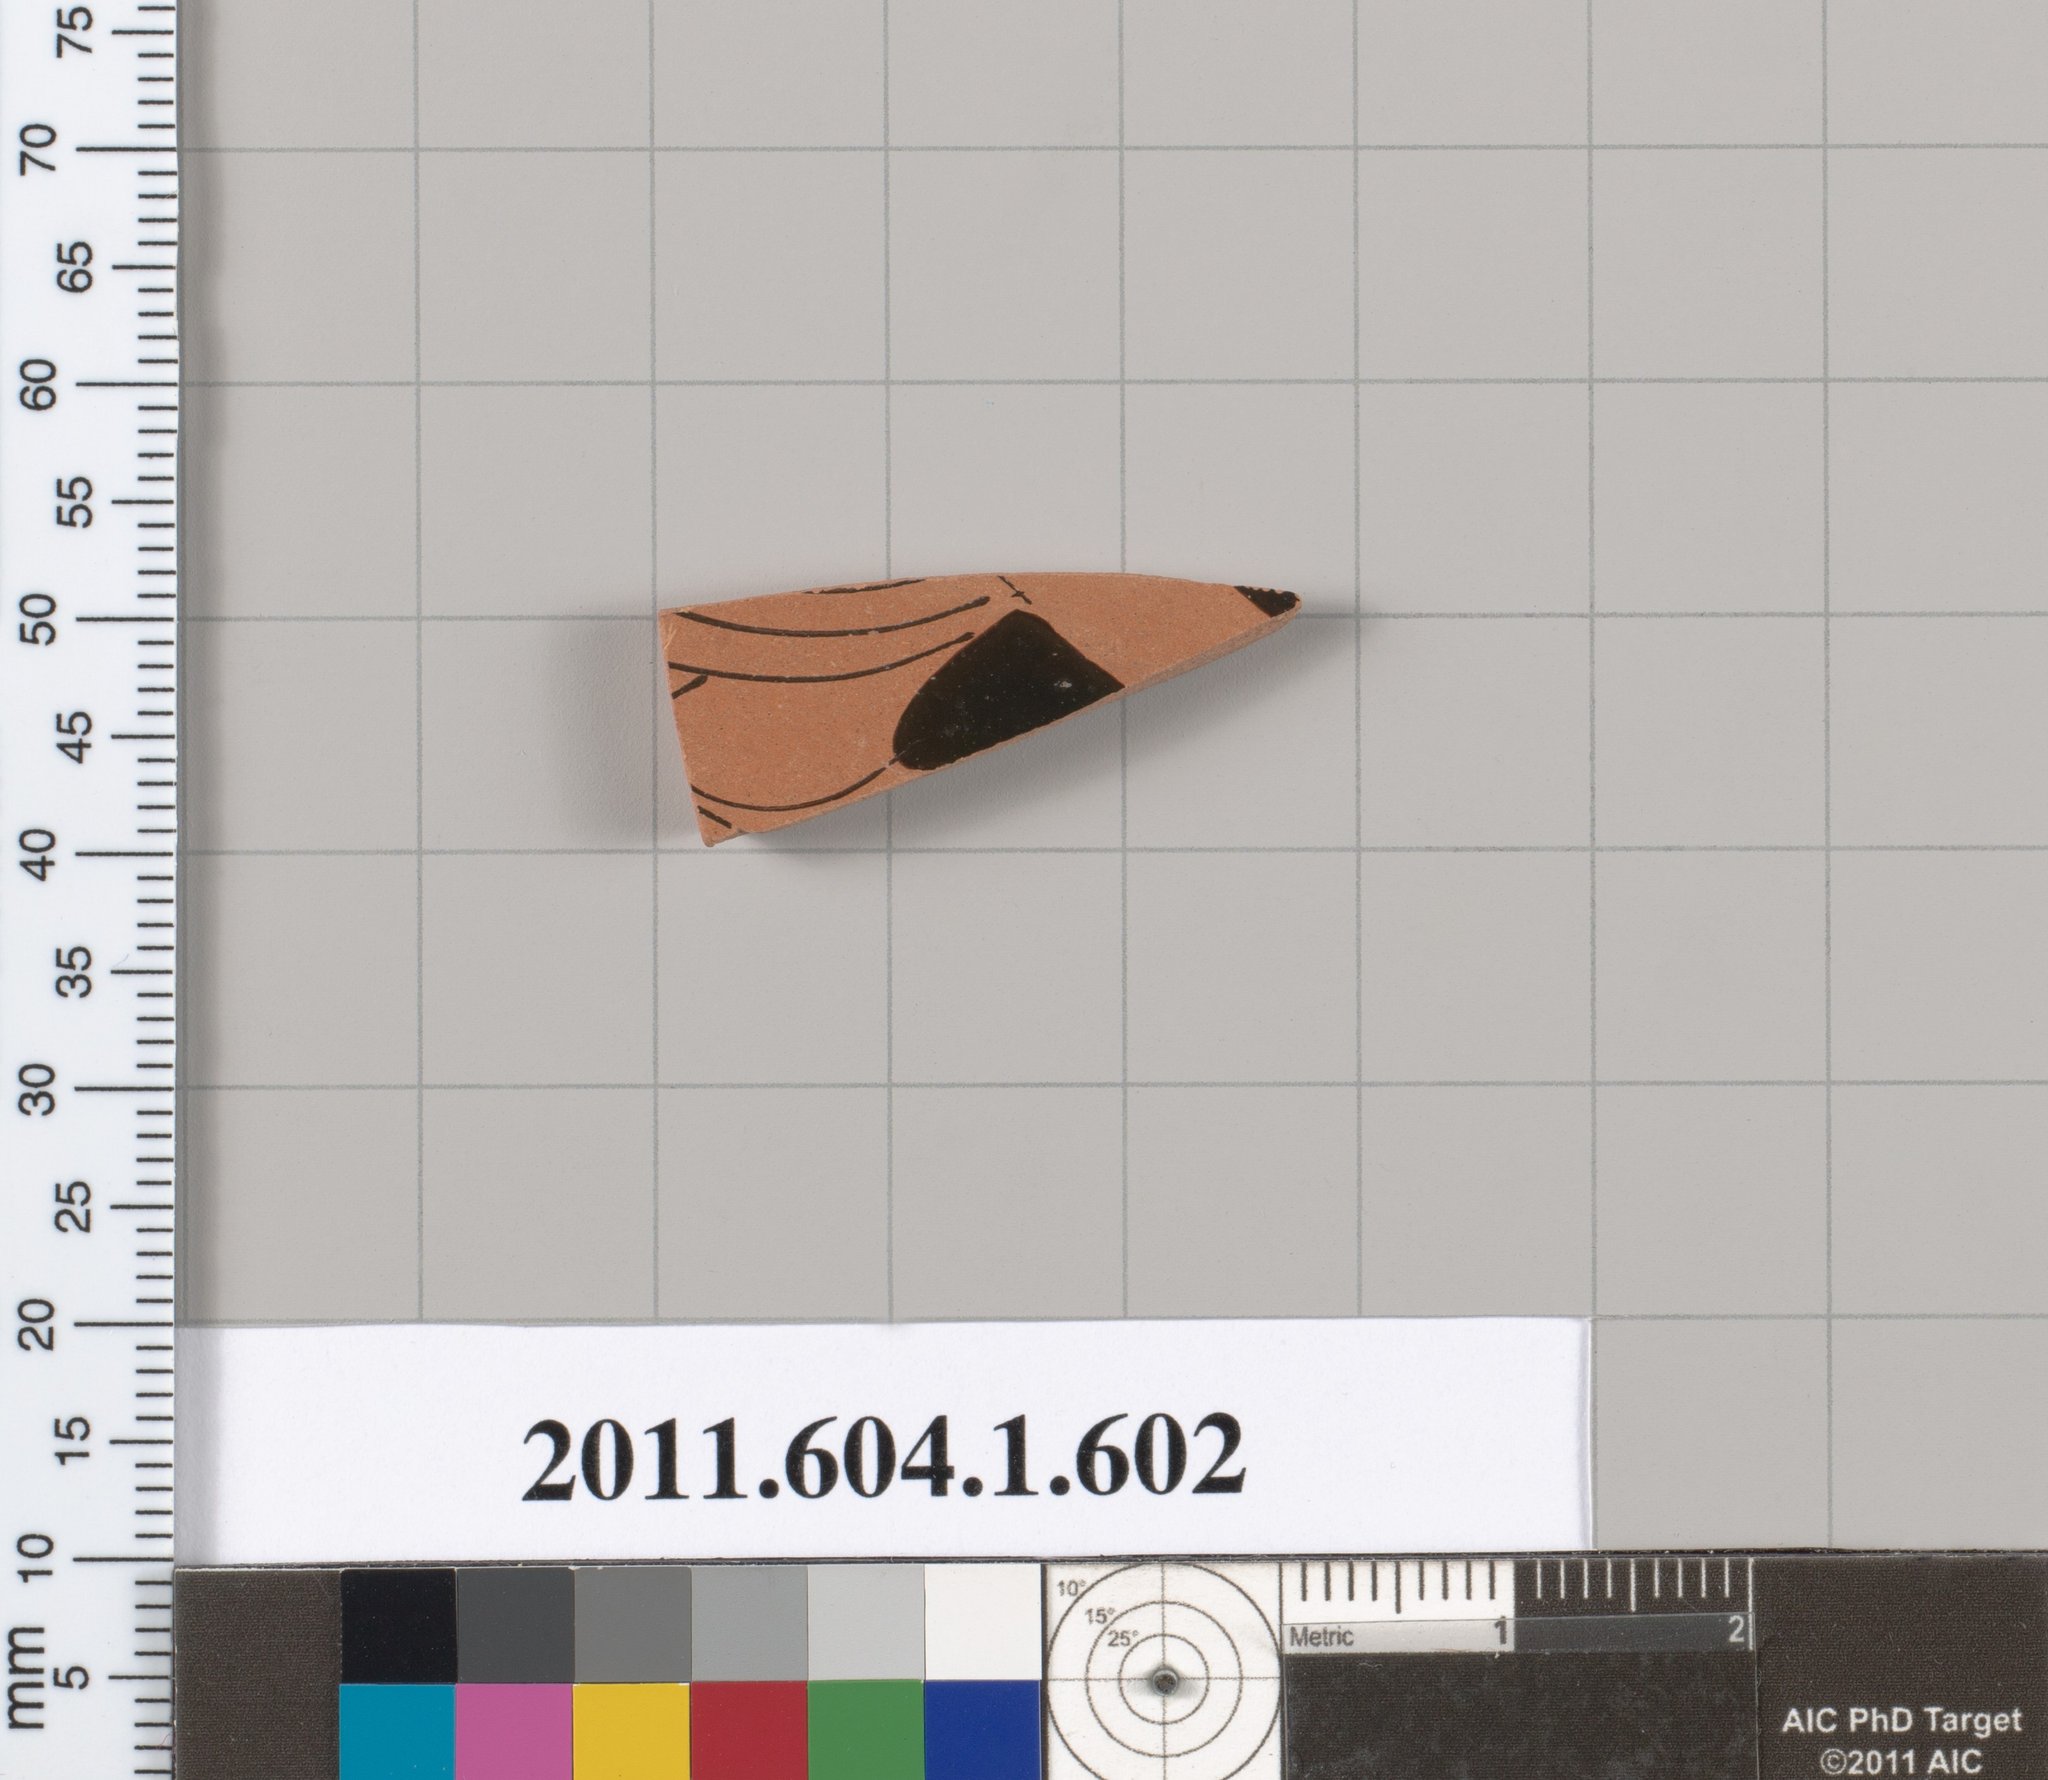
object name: kylix fragment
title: Terracotta fragment of a kylix (drinking cup)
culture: greek, attic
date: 475-451 BCE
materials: terracotta